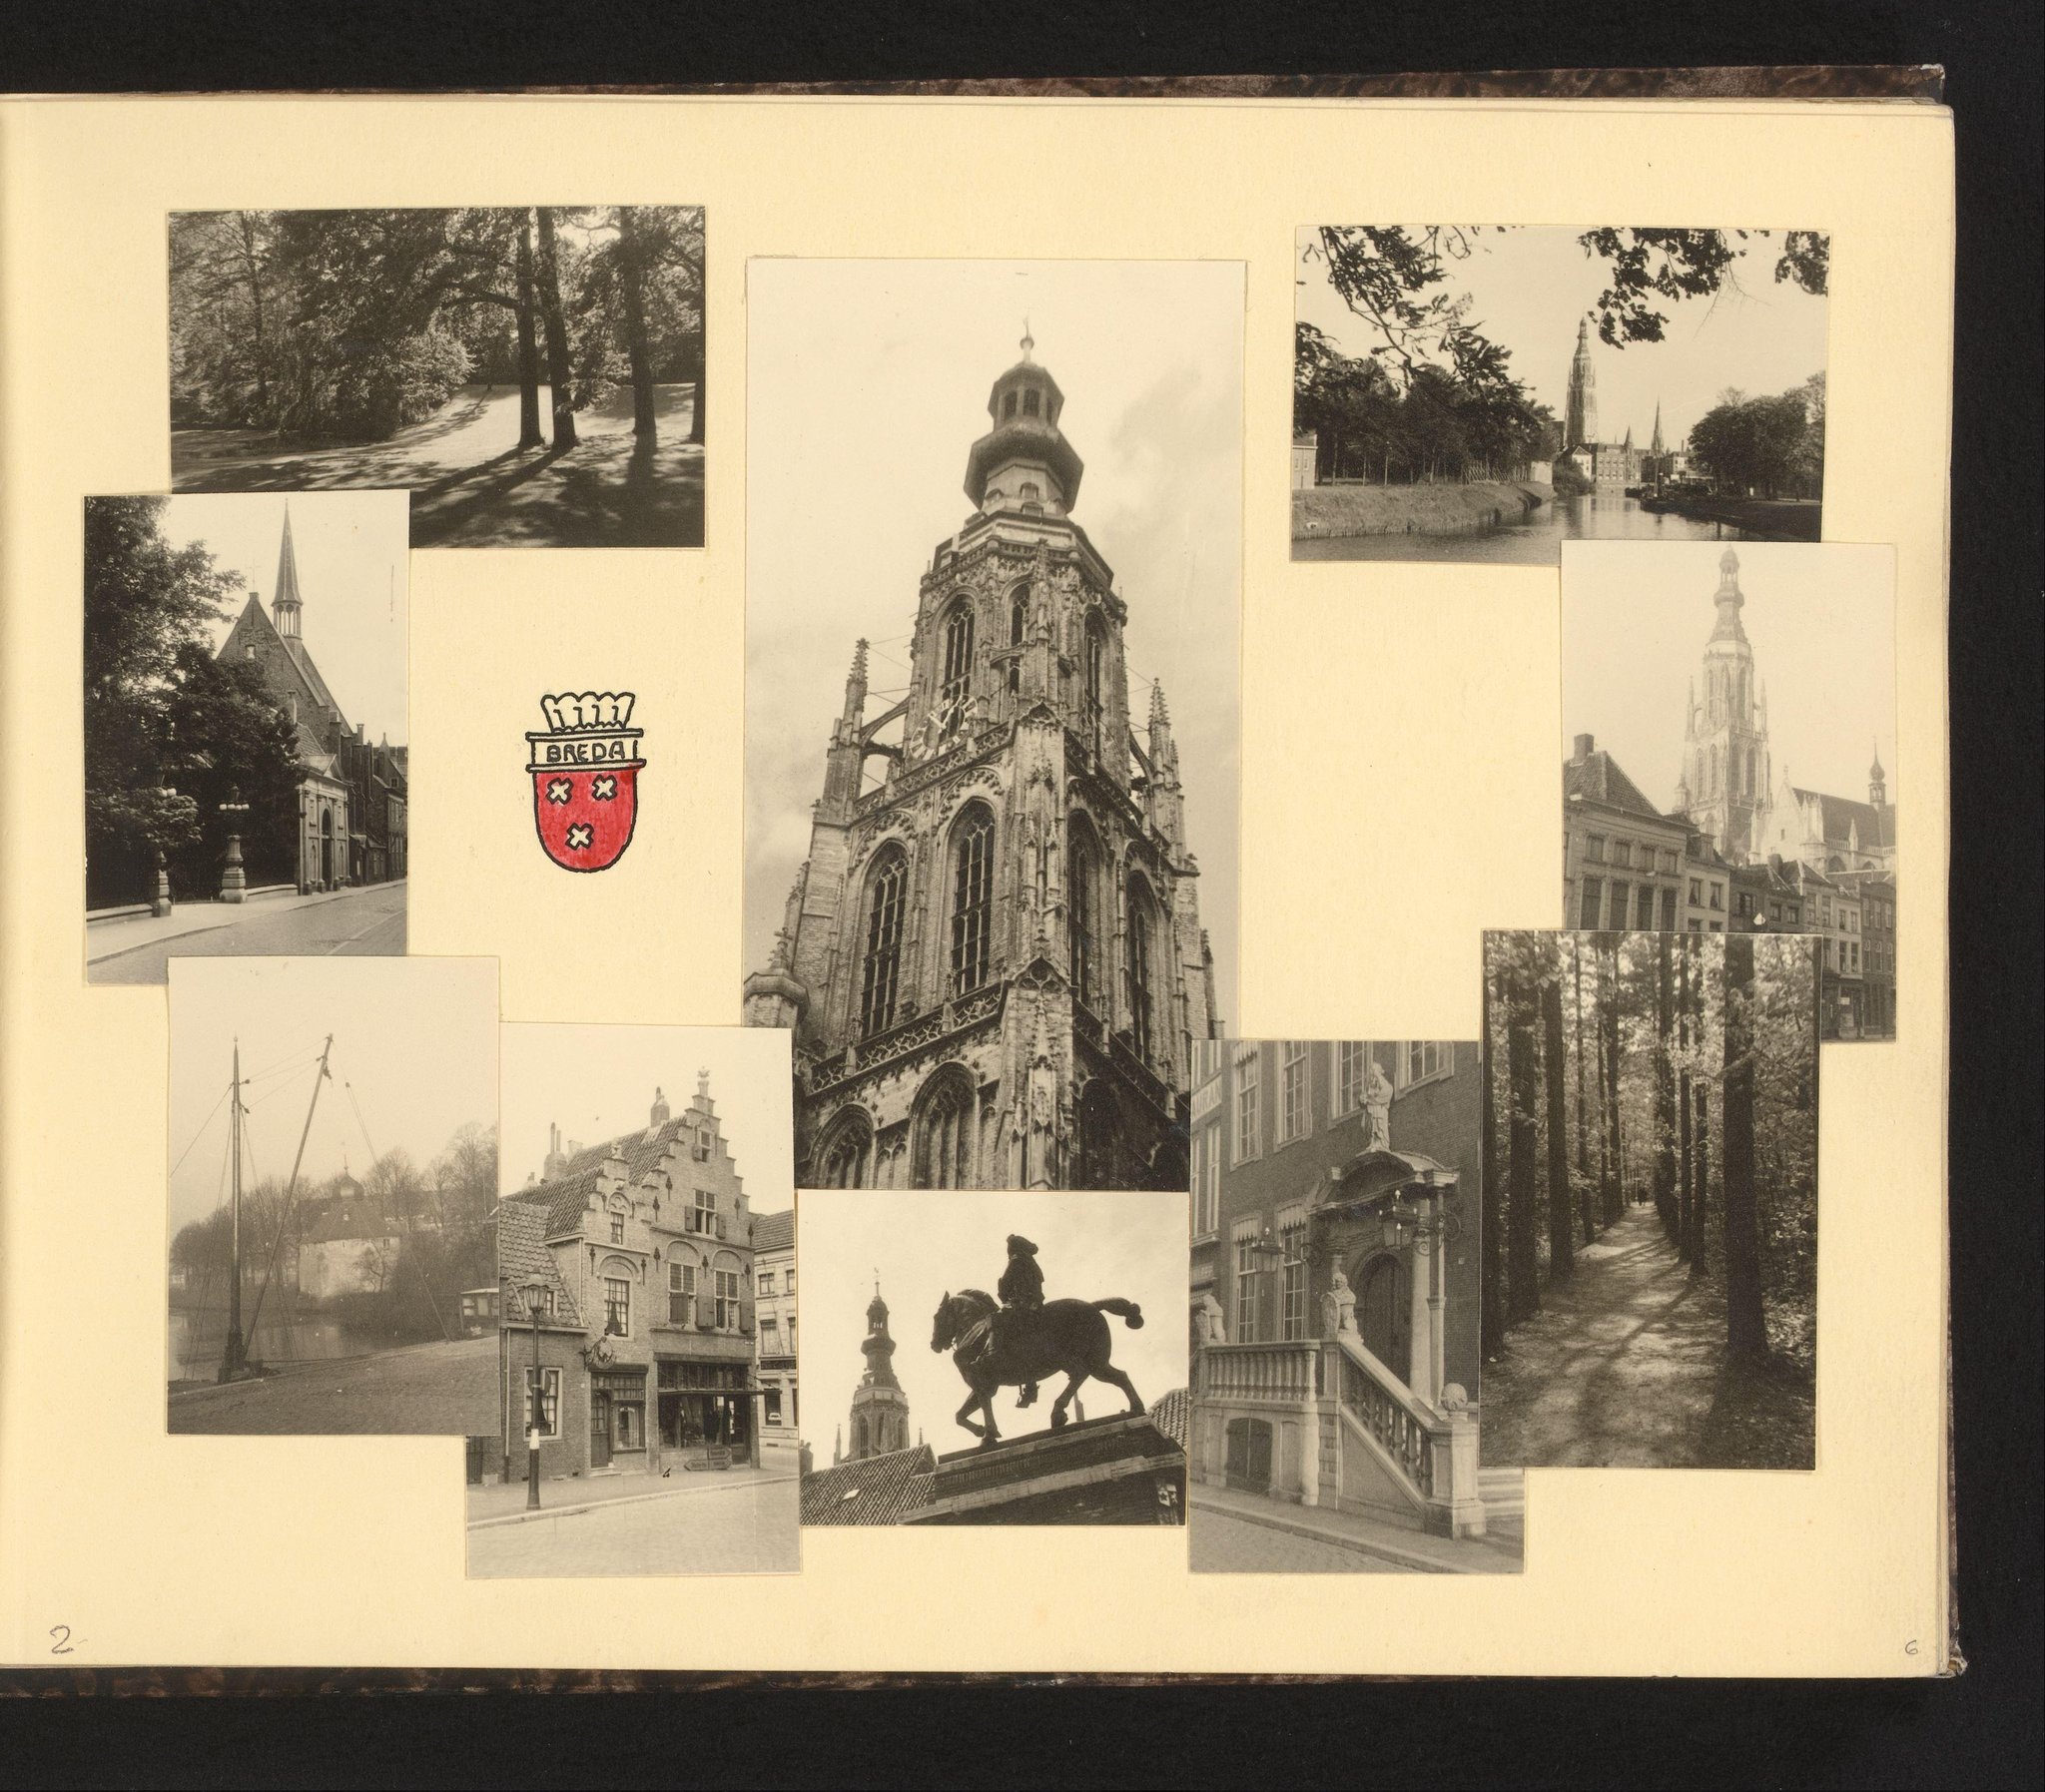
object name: photograph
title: Breda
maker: Anonymous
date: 1942-1943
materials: cardboard, photographic support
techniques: gelatin silver print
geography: breda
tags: city-view in general; 'veduta', church (exterior)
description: Albumblad met een collage van tien verknipte foto's van gezichten te Breda. Hiertussen ook een getekend stadswapen. Onderdeel van het fotoalbum van de Luftnachrichten-Regiment 211,1942-1943.